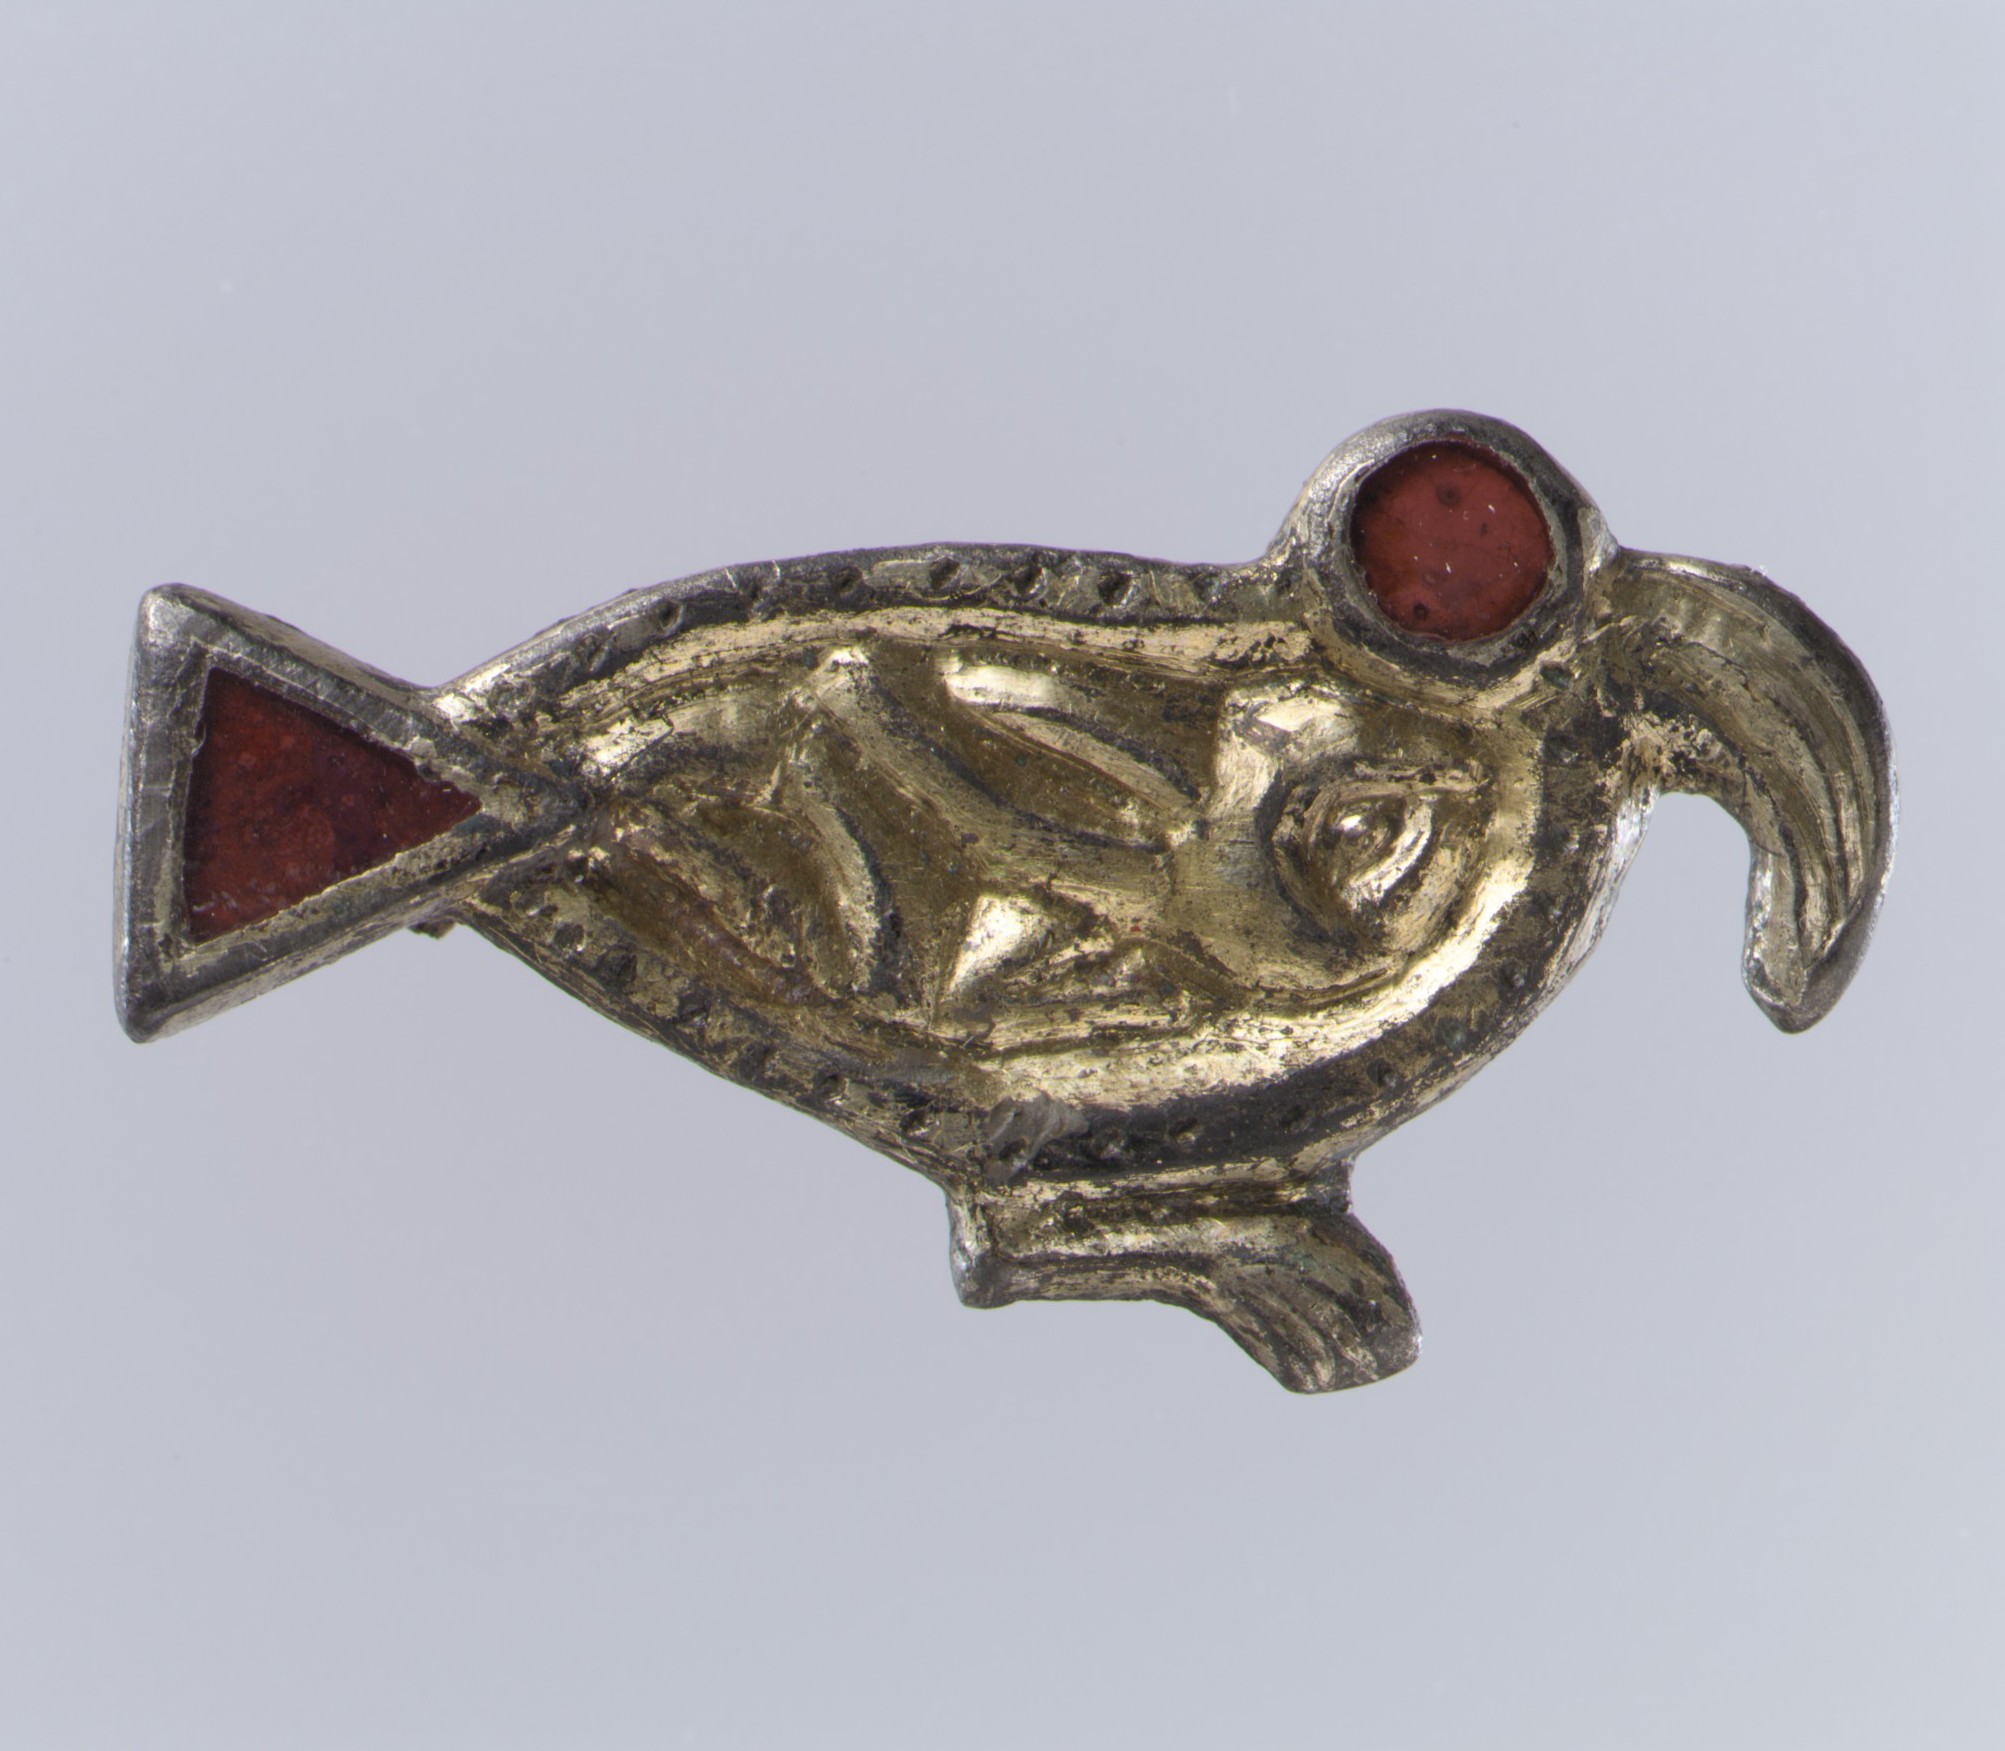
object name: brooch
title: Bird-Shaped Brooch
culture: anglo-saxon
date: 500-550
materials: garnet, silver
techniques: gilding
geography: england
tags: birds